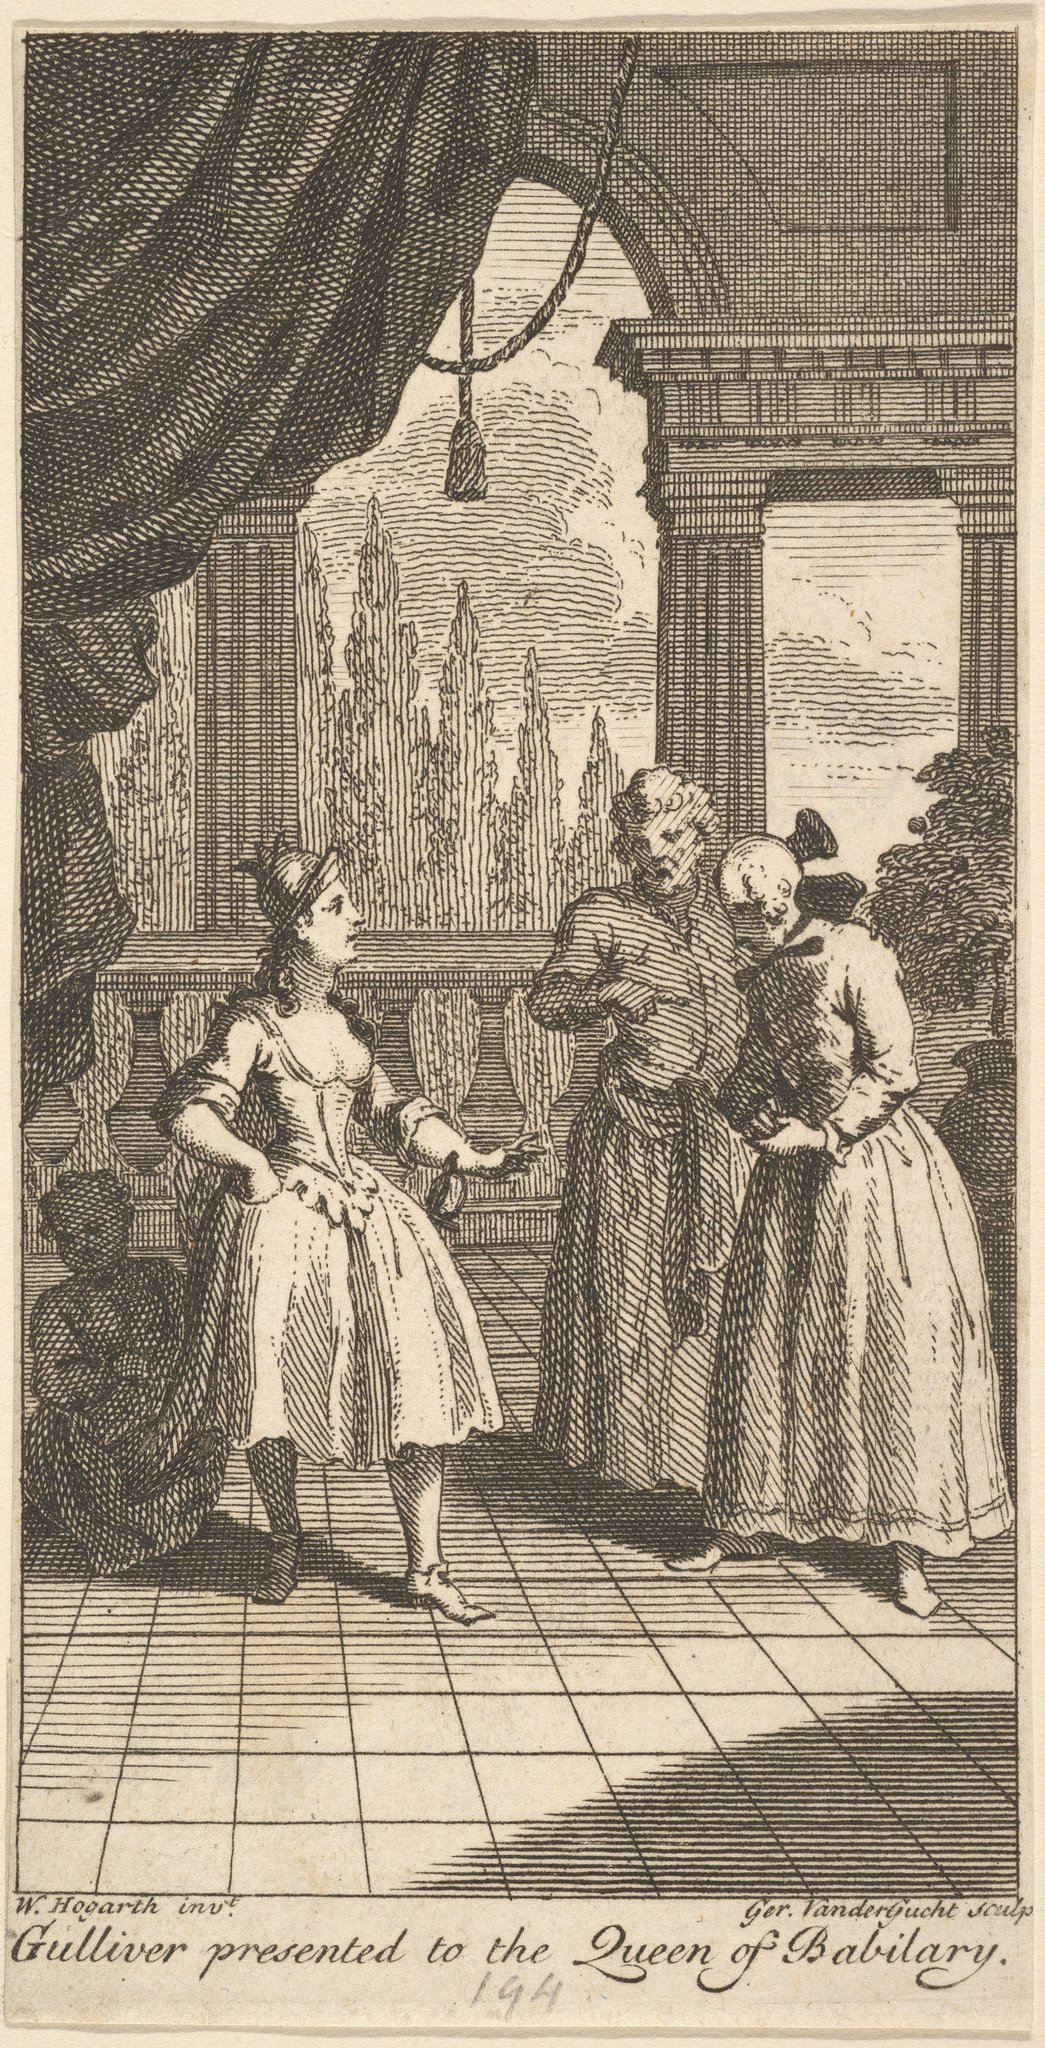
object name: print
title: Gulliver Presented to the Queen of Babilary, Frontispiece to "The Travels of Mr. John Gulliver"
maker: gerard vandergucht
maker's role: engraver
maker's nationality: british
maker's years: 1696-1776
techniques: engraving, etching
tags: queens,women